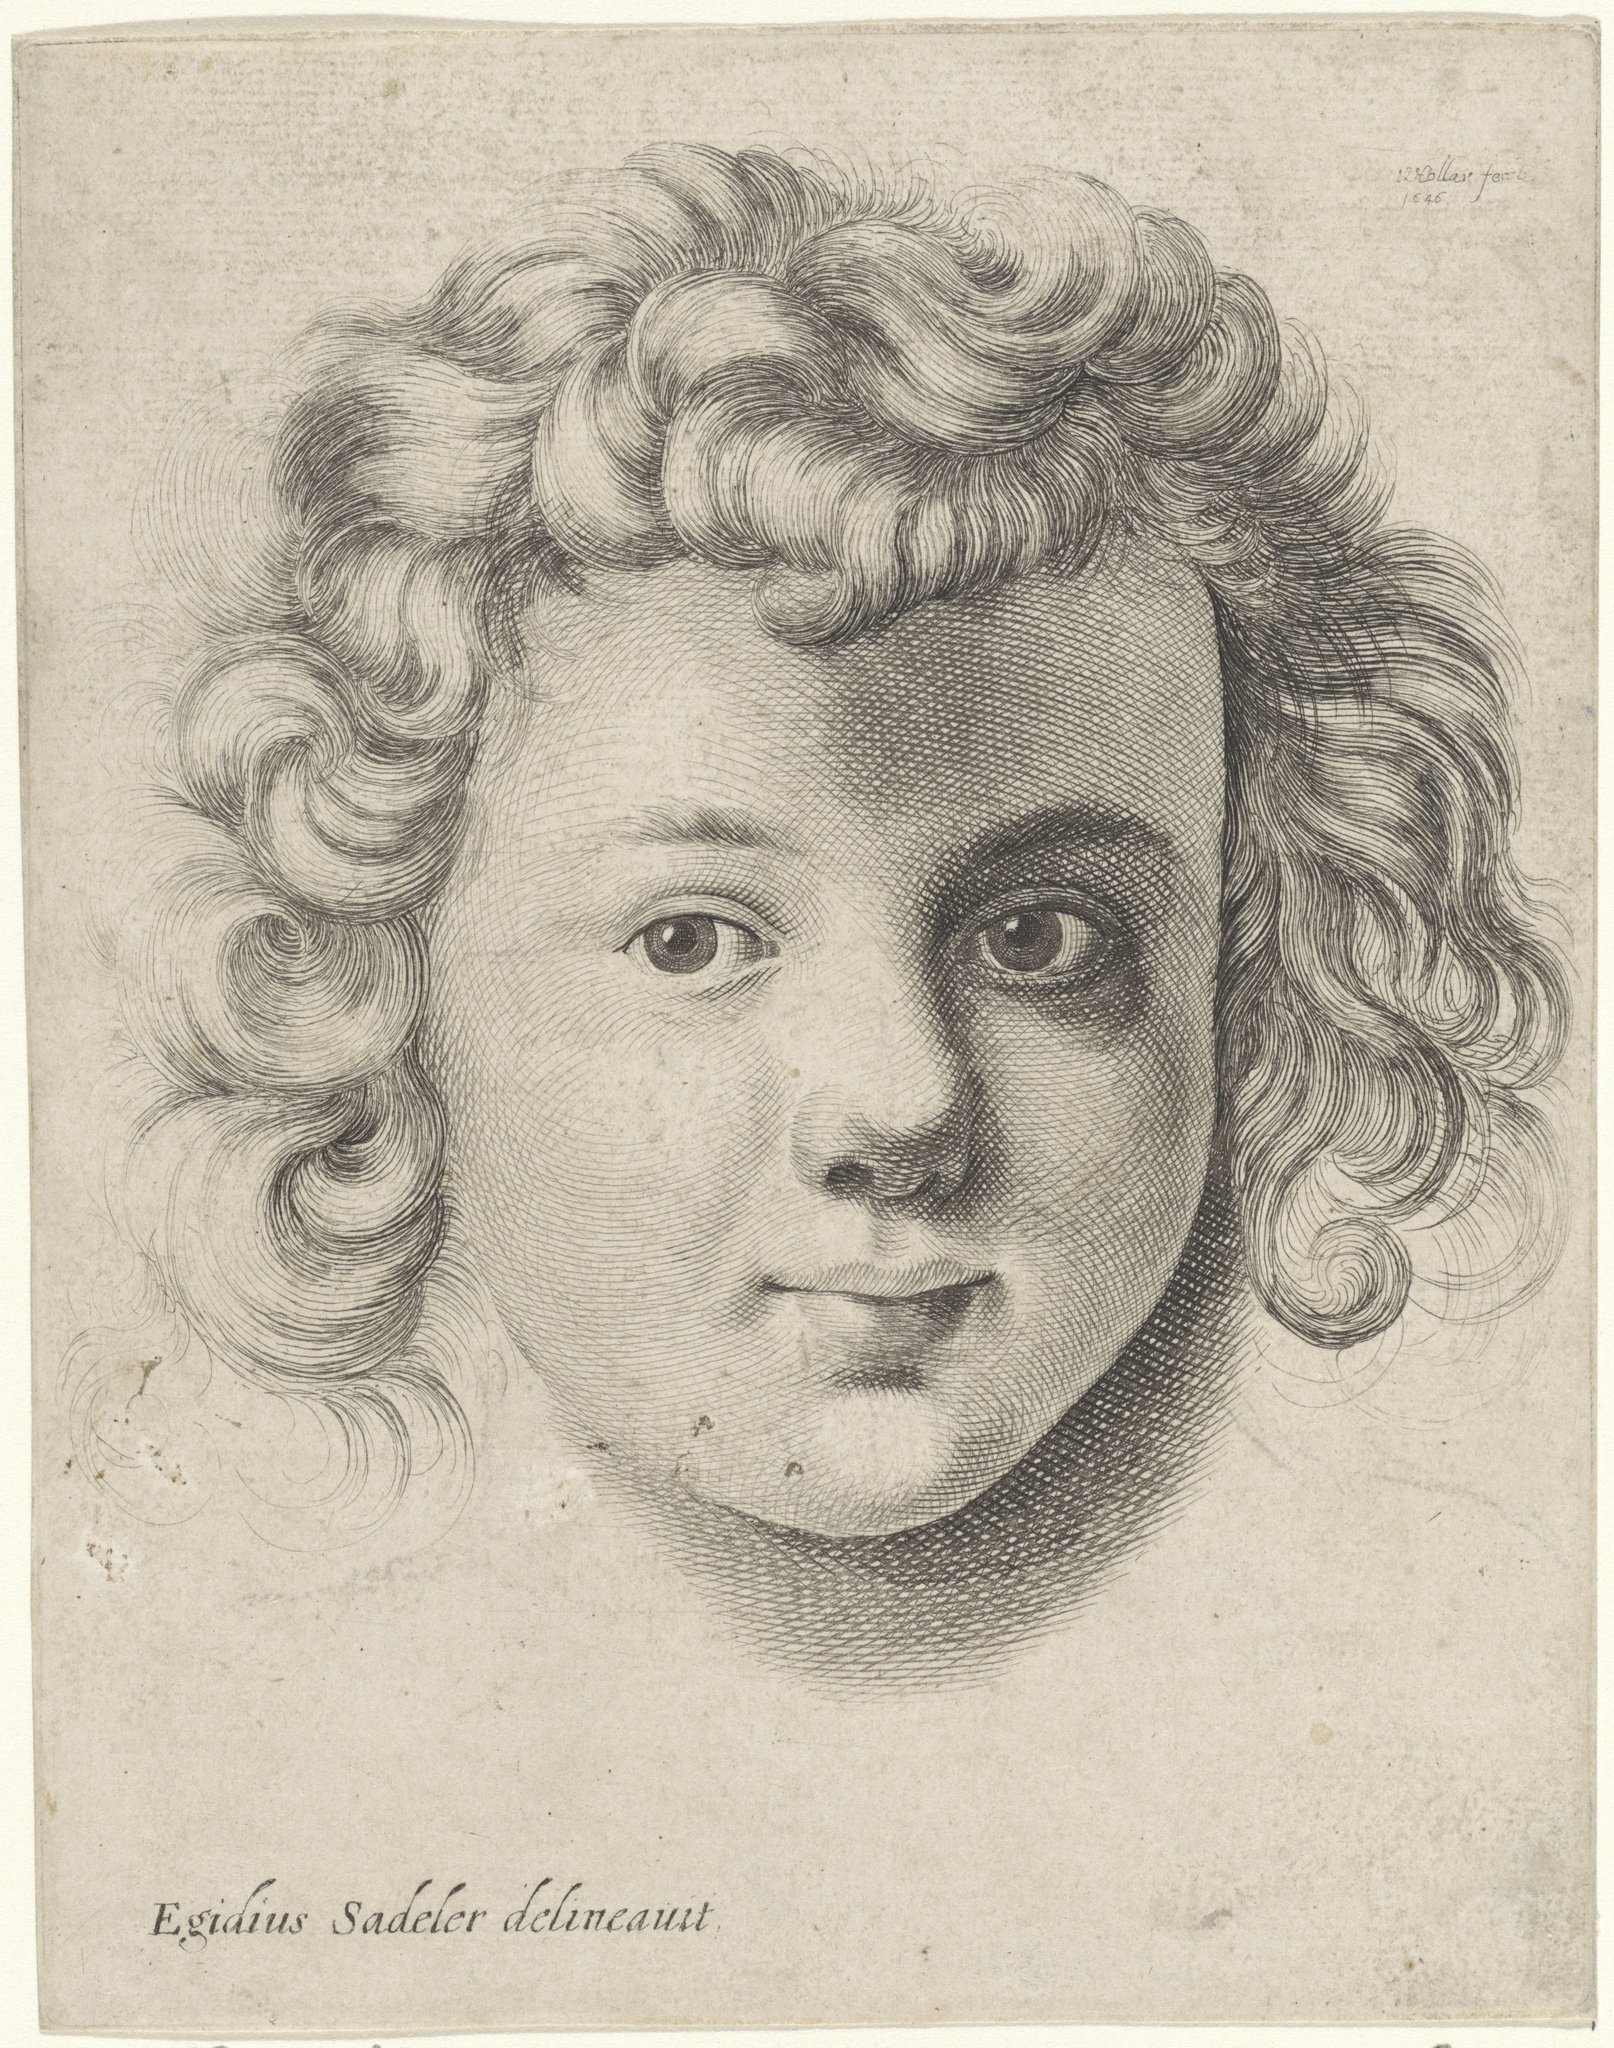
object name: print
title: Hoofd van een kind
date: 1646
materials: paper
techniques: etching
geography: antwerp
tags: head (human), child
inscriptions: collector's mark: Lugt 240